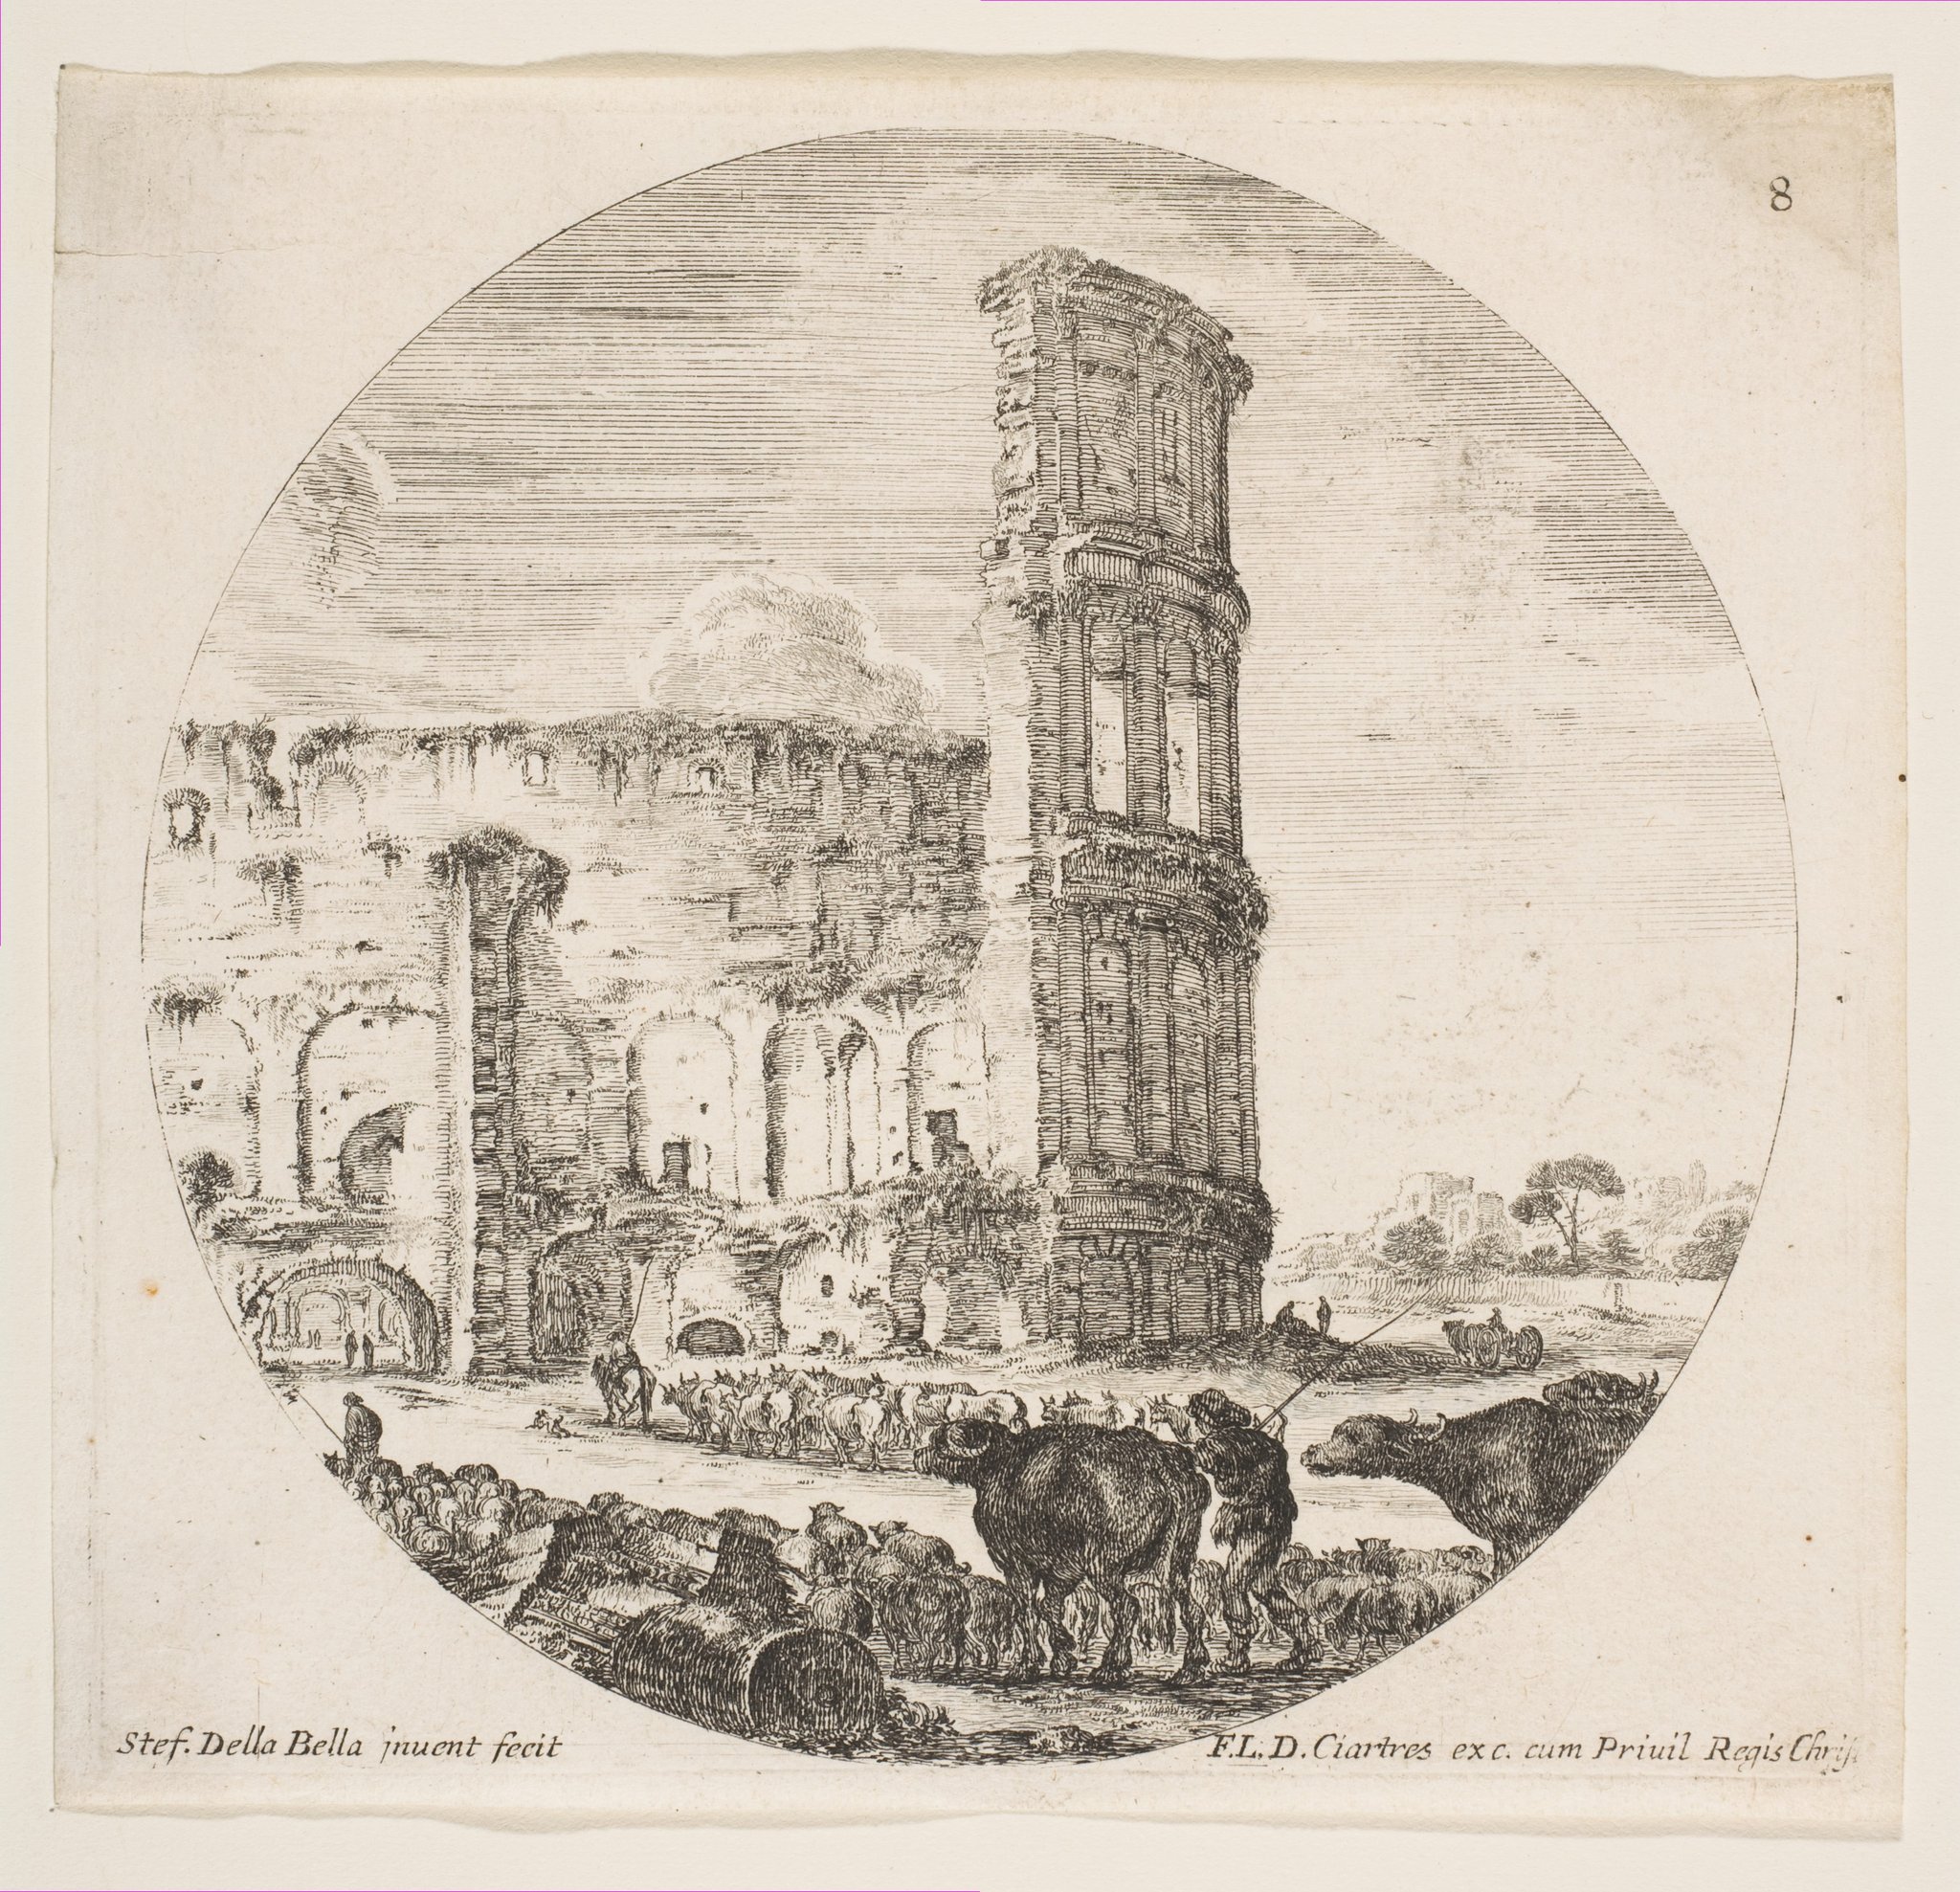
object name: print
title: The Colosseum, two herds being directed towards the amphitheater in the foreground, plate 8 from "Roman landscapes and ruins" (Paysages et ruines de Rome)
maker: stefano della bella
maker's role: artist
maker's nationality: italian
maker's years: 1610-1664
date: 1646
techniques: etching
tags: ruins,men,buffalos,rome